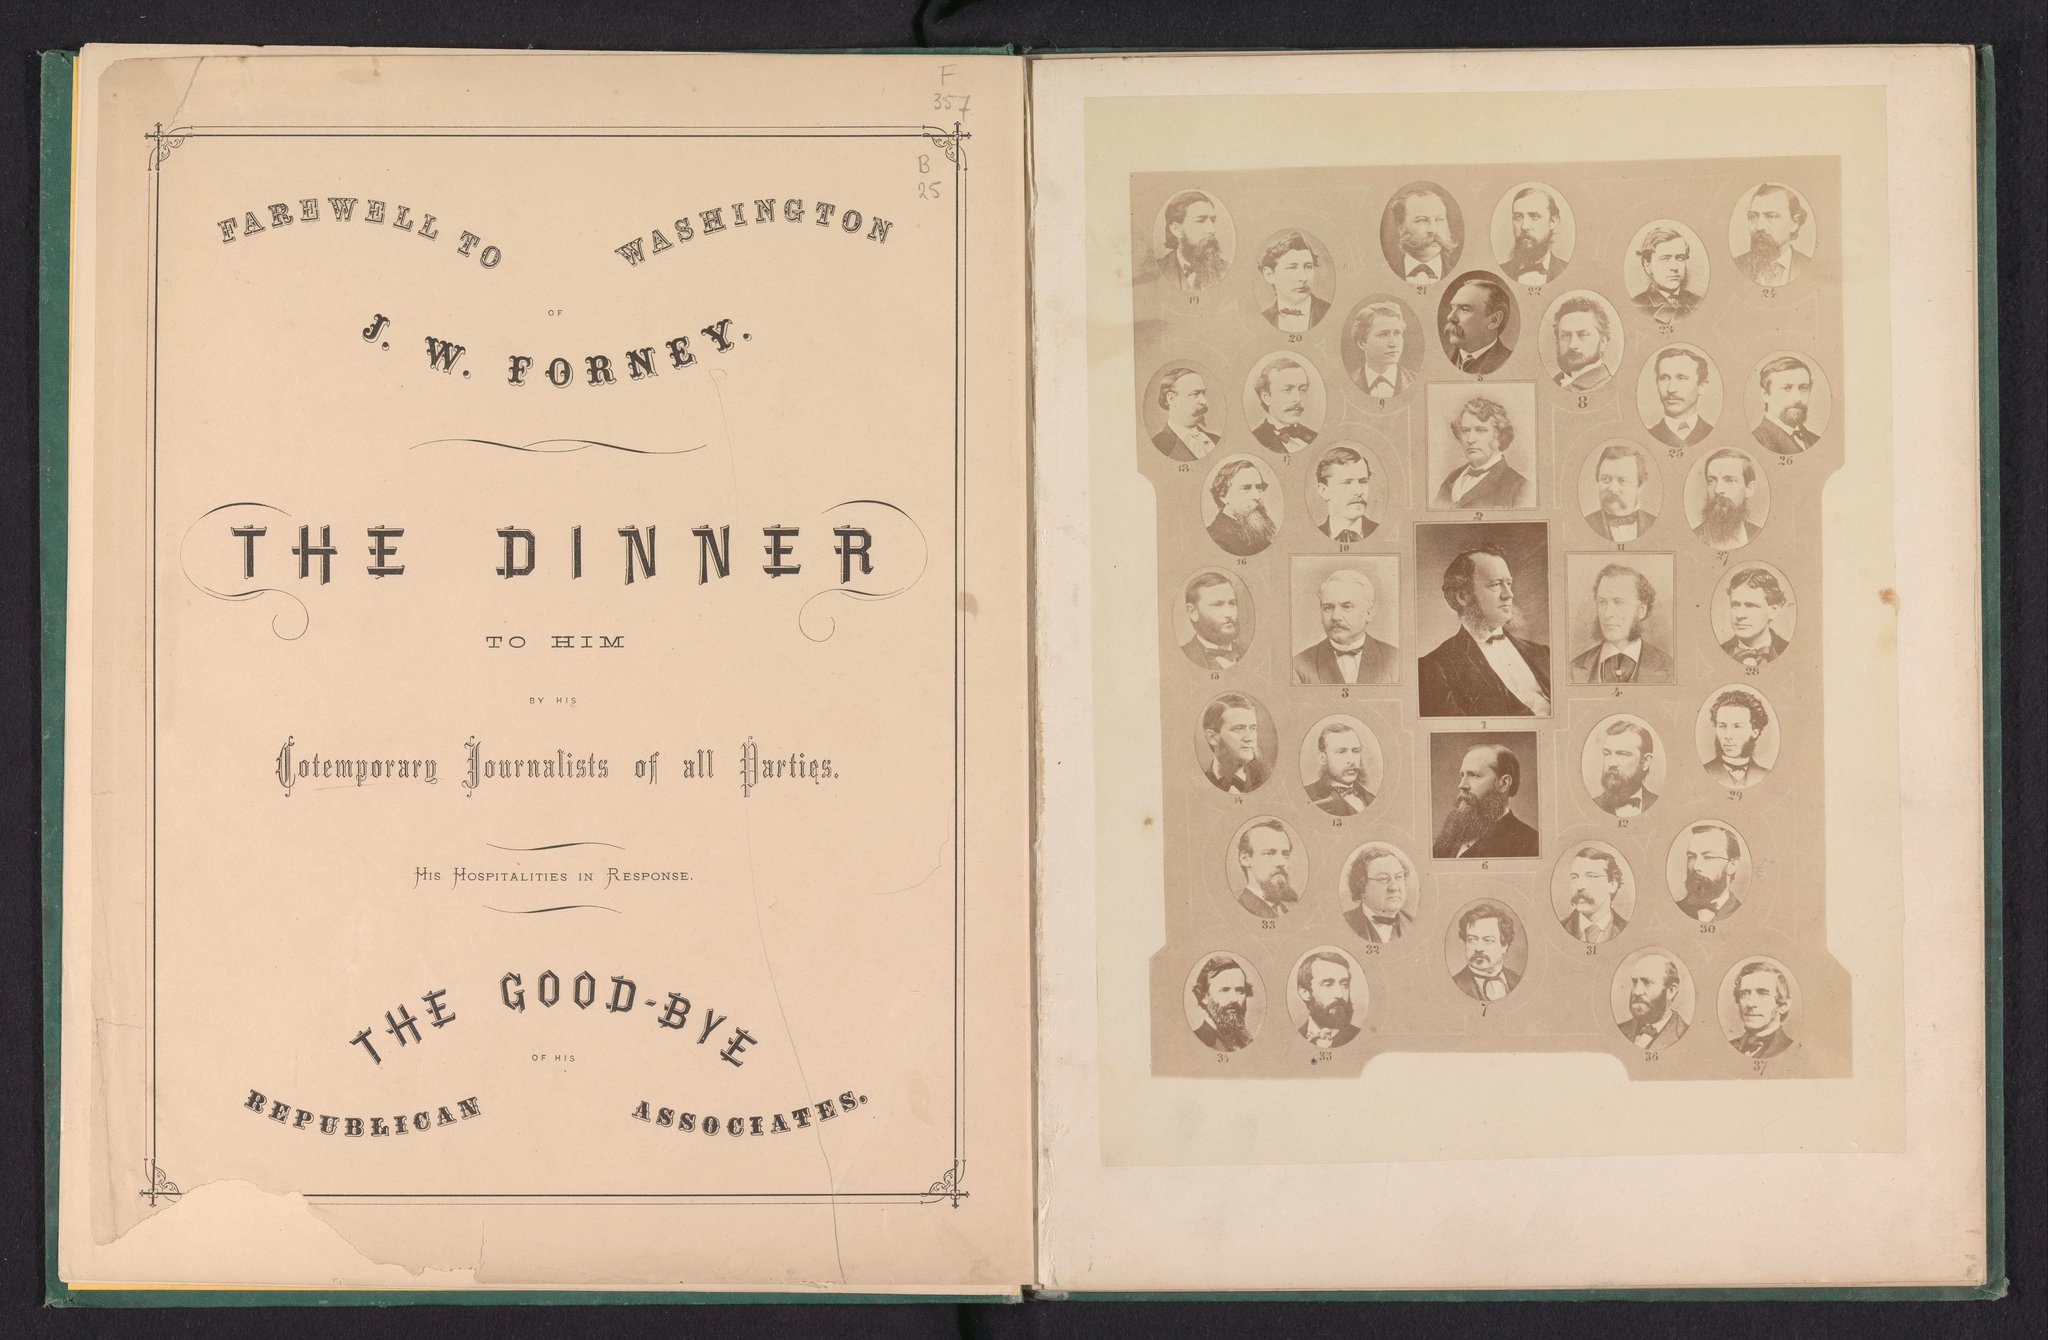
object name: page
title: Fotomontage van 37 journalisten aanwezig bij het afscheidsdiner van John Weiss Forney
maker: Anonymous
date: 1866-1871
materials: photographic support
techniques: albumen print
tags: journalist, reporter